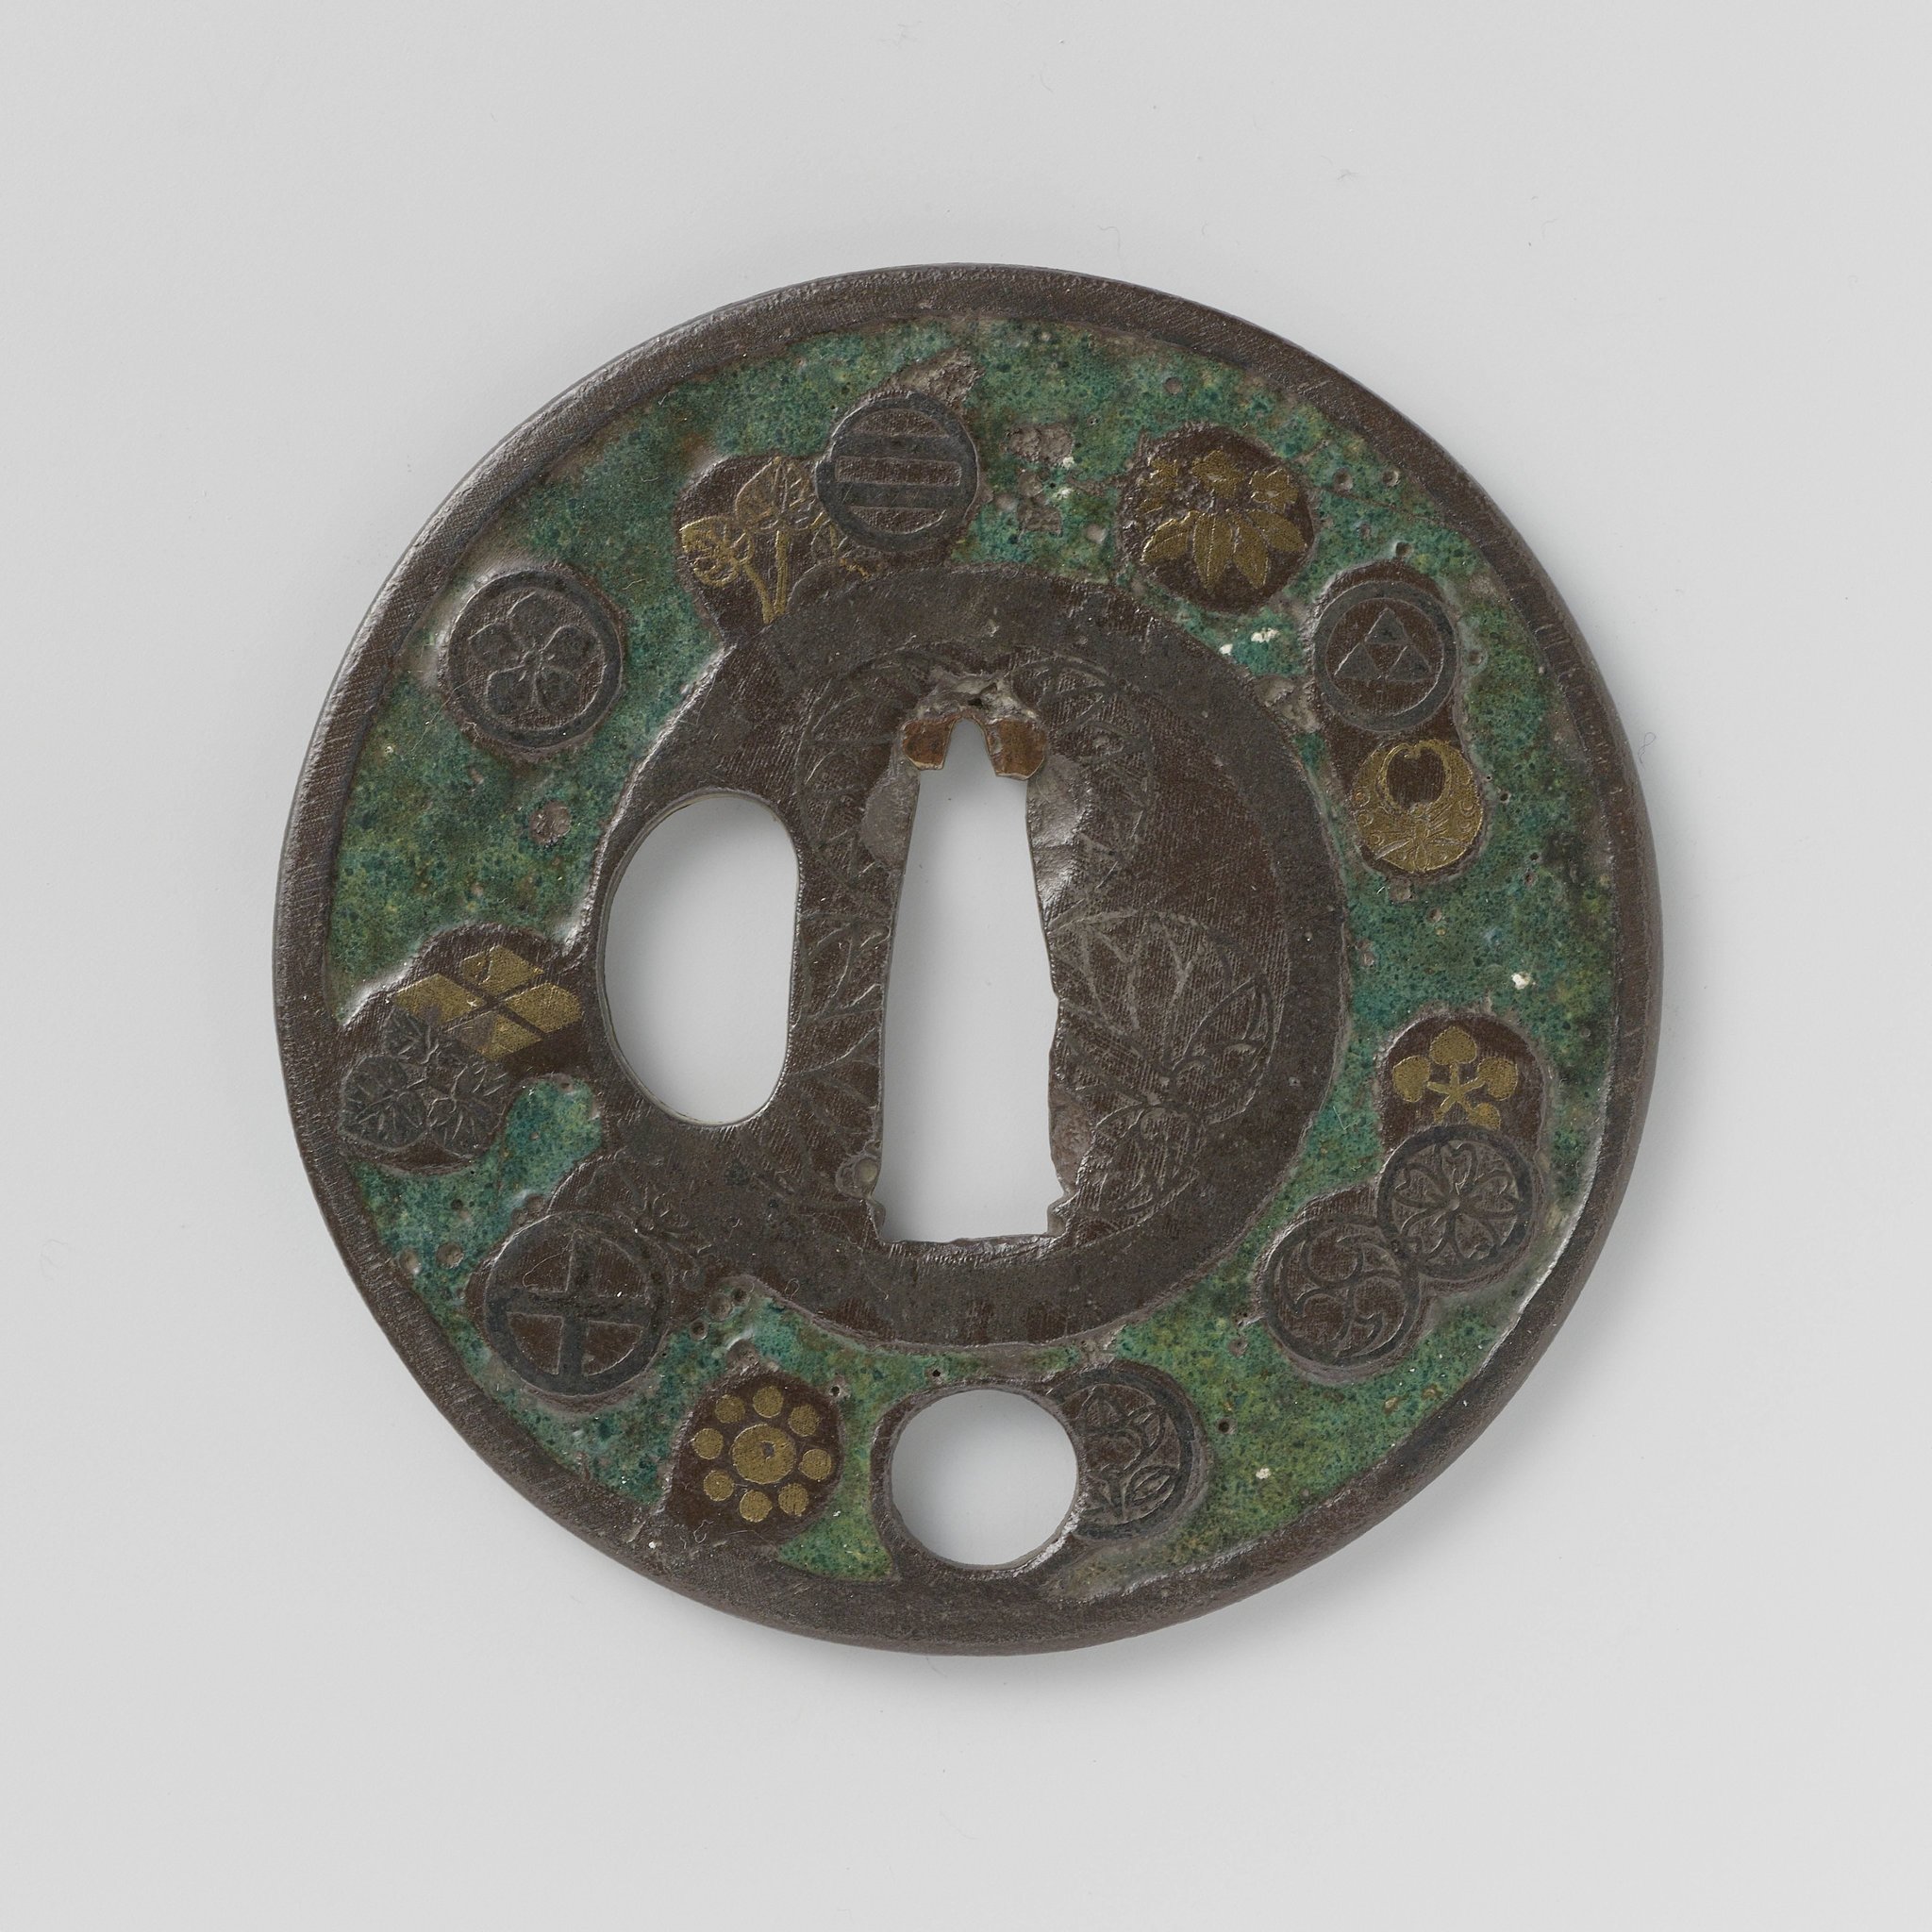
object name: tsuba, zwaardstootplaat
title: Hand guard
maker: Anonymous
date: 1600-1800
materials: gold, iron, silver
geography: hirado